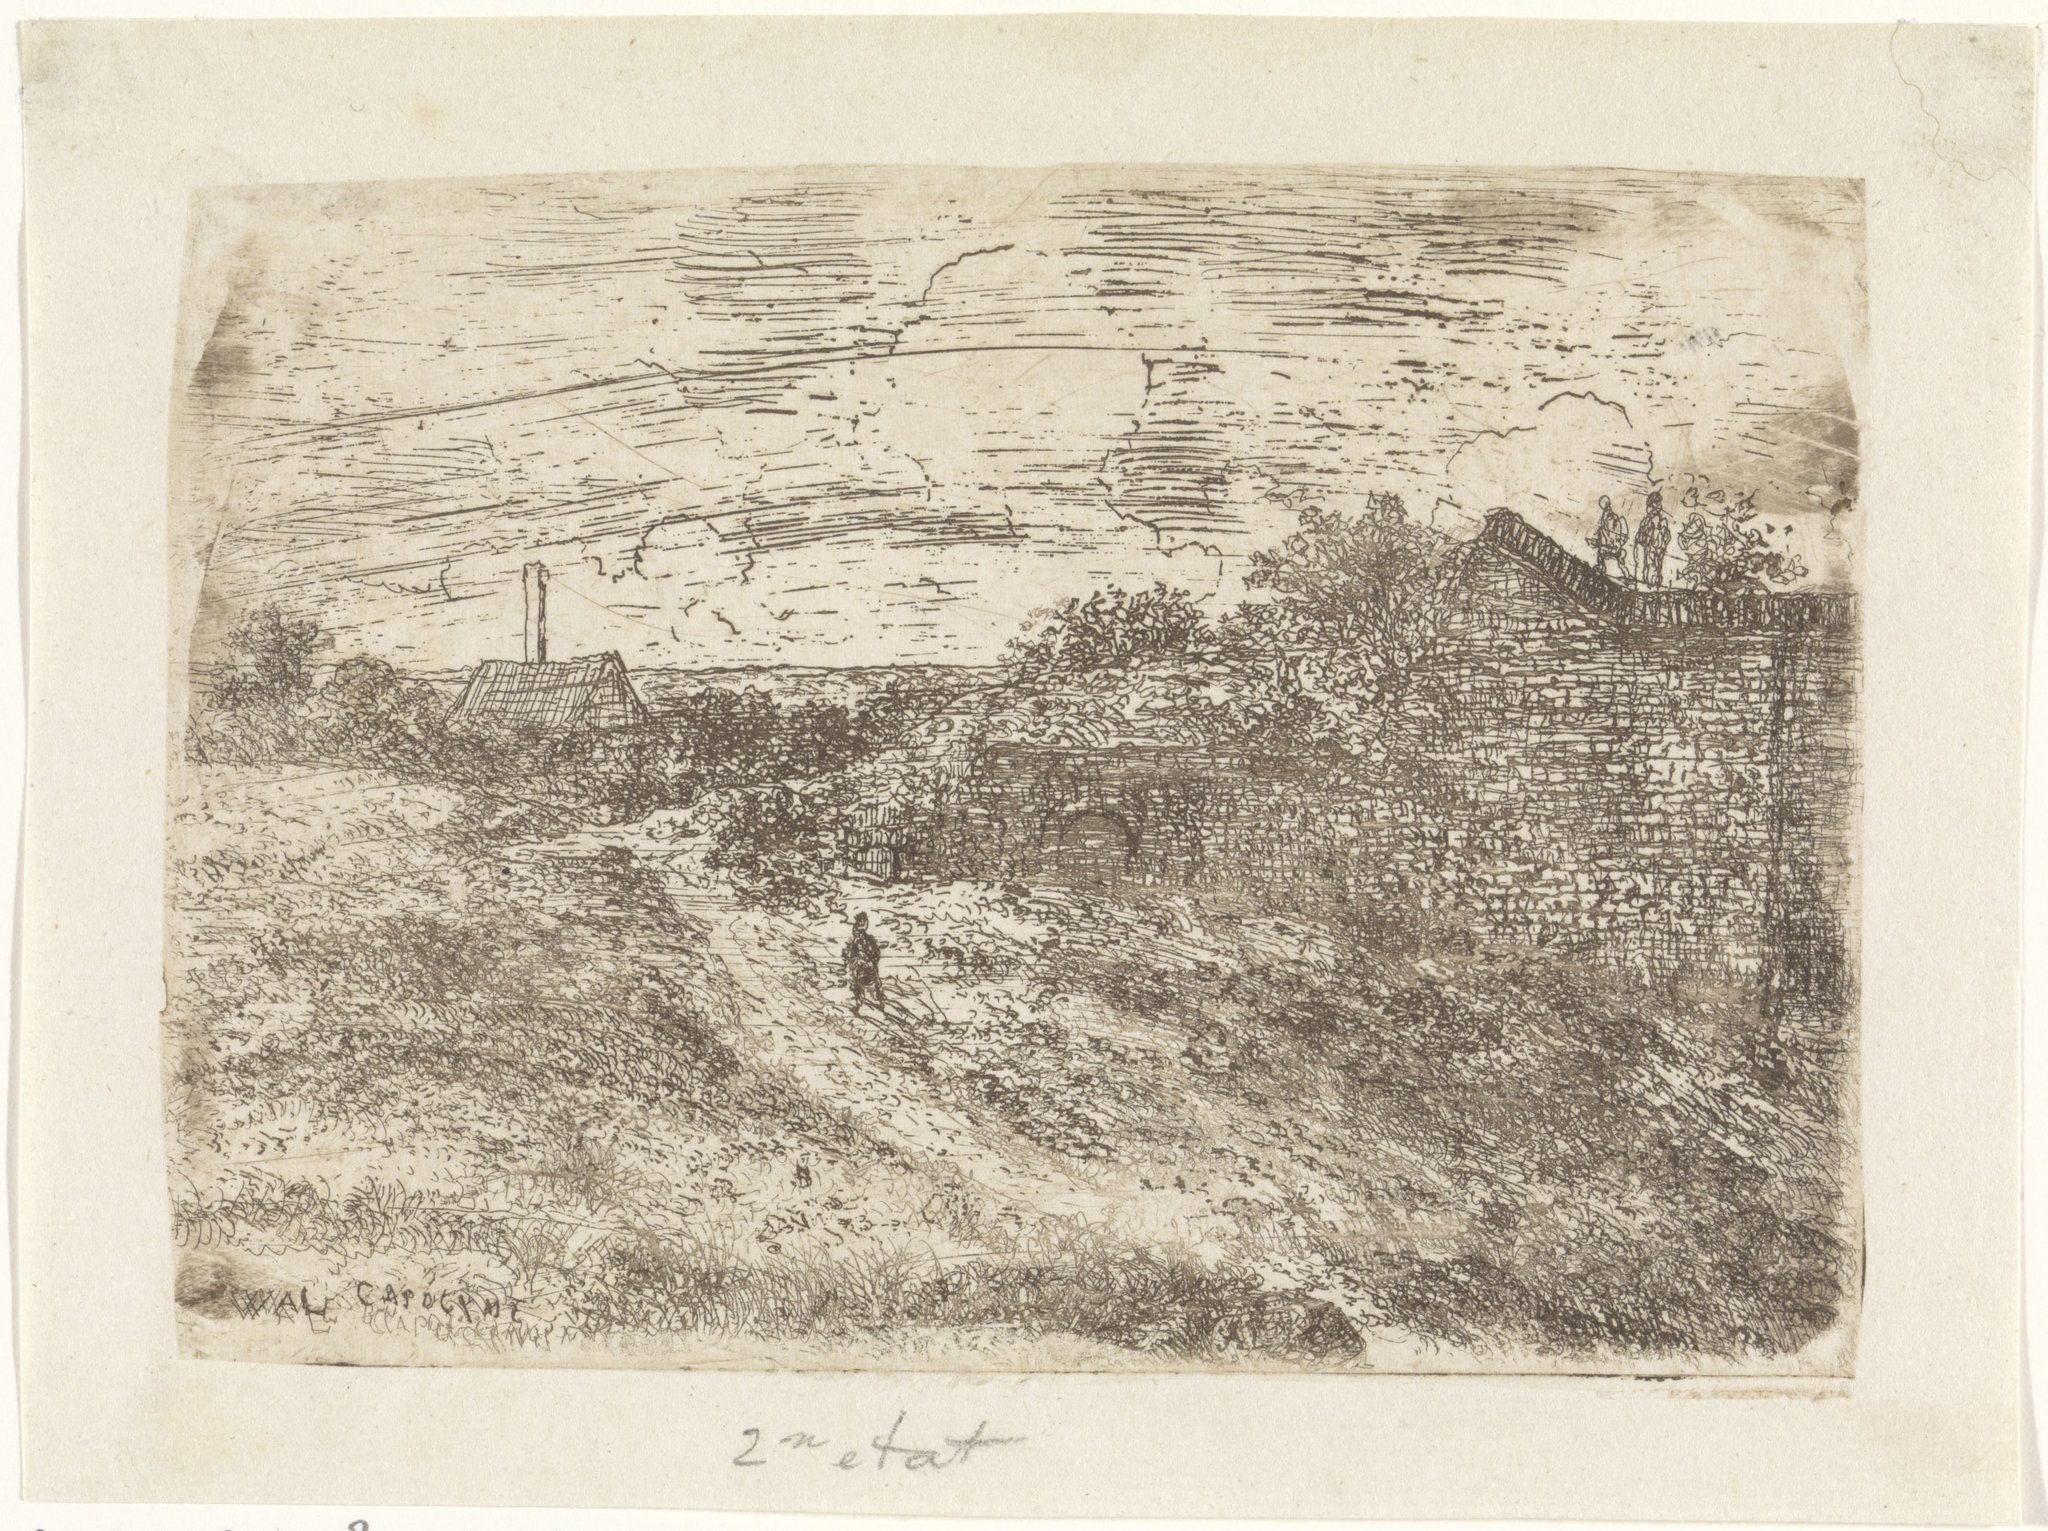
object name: print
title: Landschap met enkele huizen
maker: alexander schaepkens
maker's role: draughtsman, print maker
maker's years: 1815-1899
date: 1830-1899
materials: paper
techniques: etching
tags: farm or solitary house in landscape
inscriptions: collector's mark: Lugt 2228